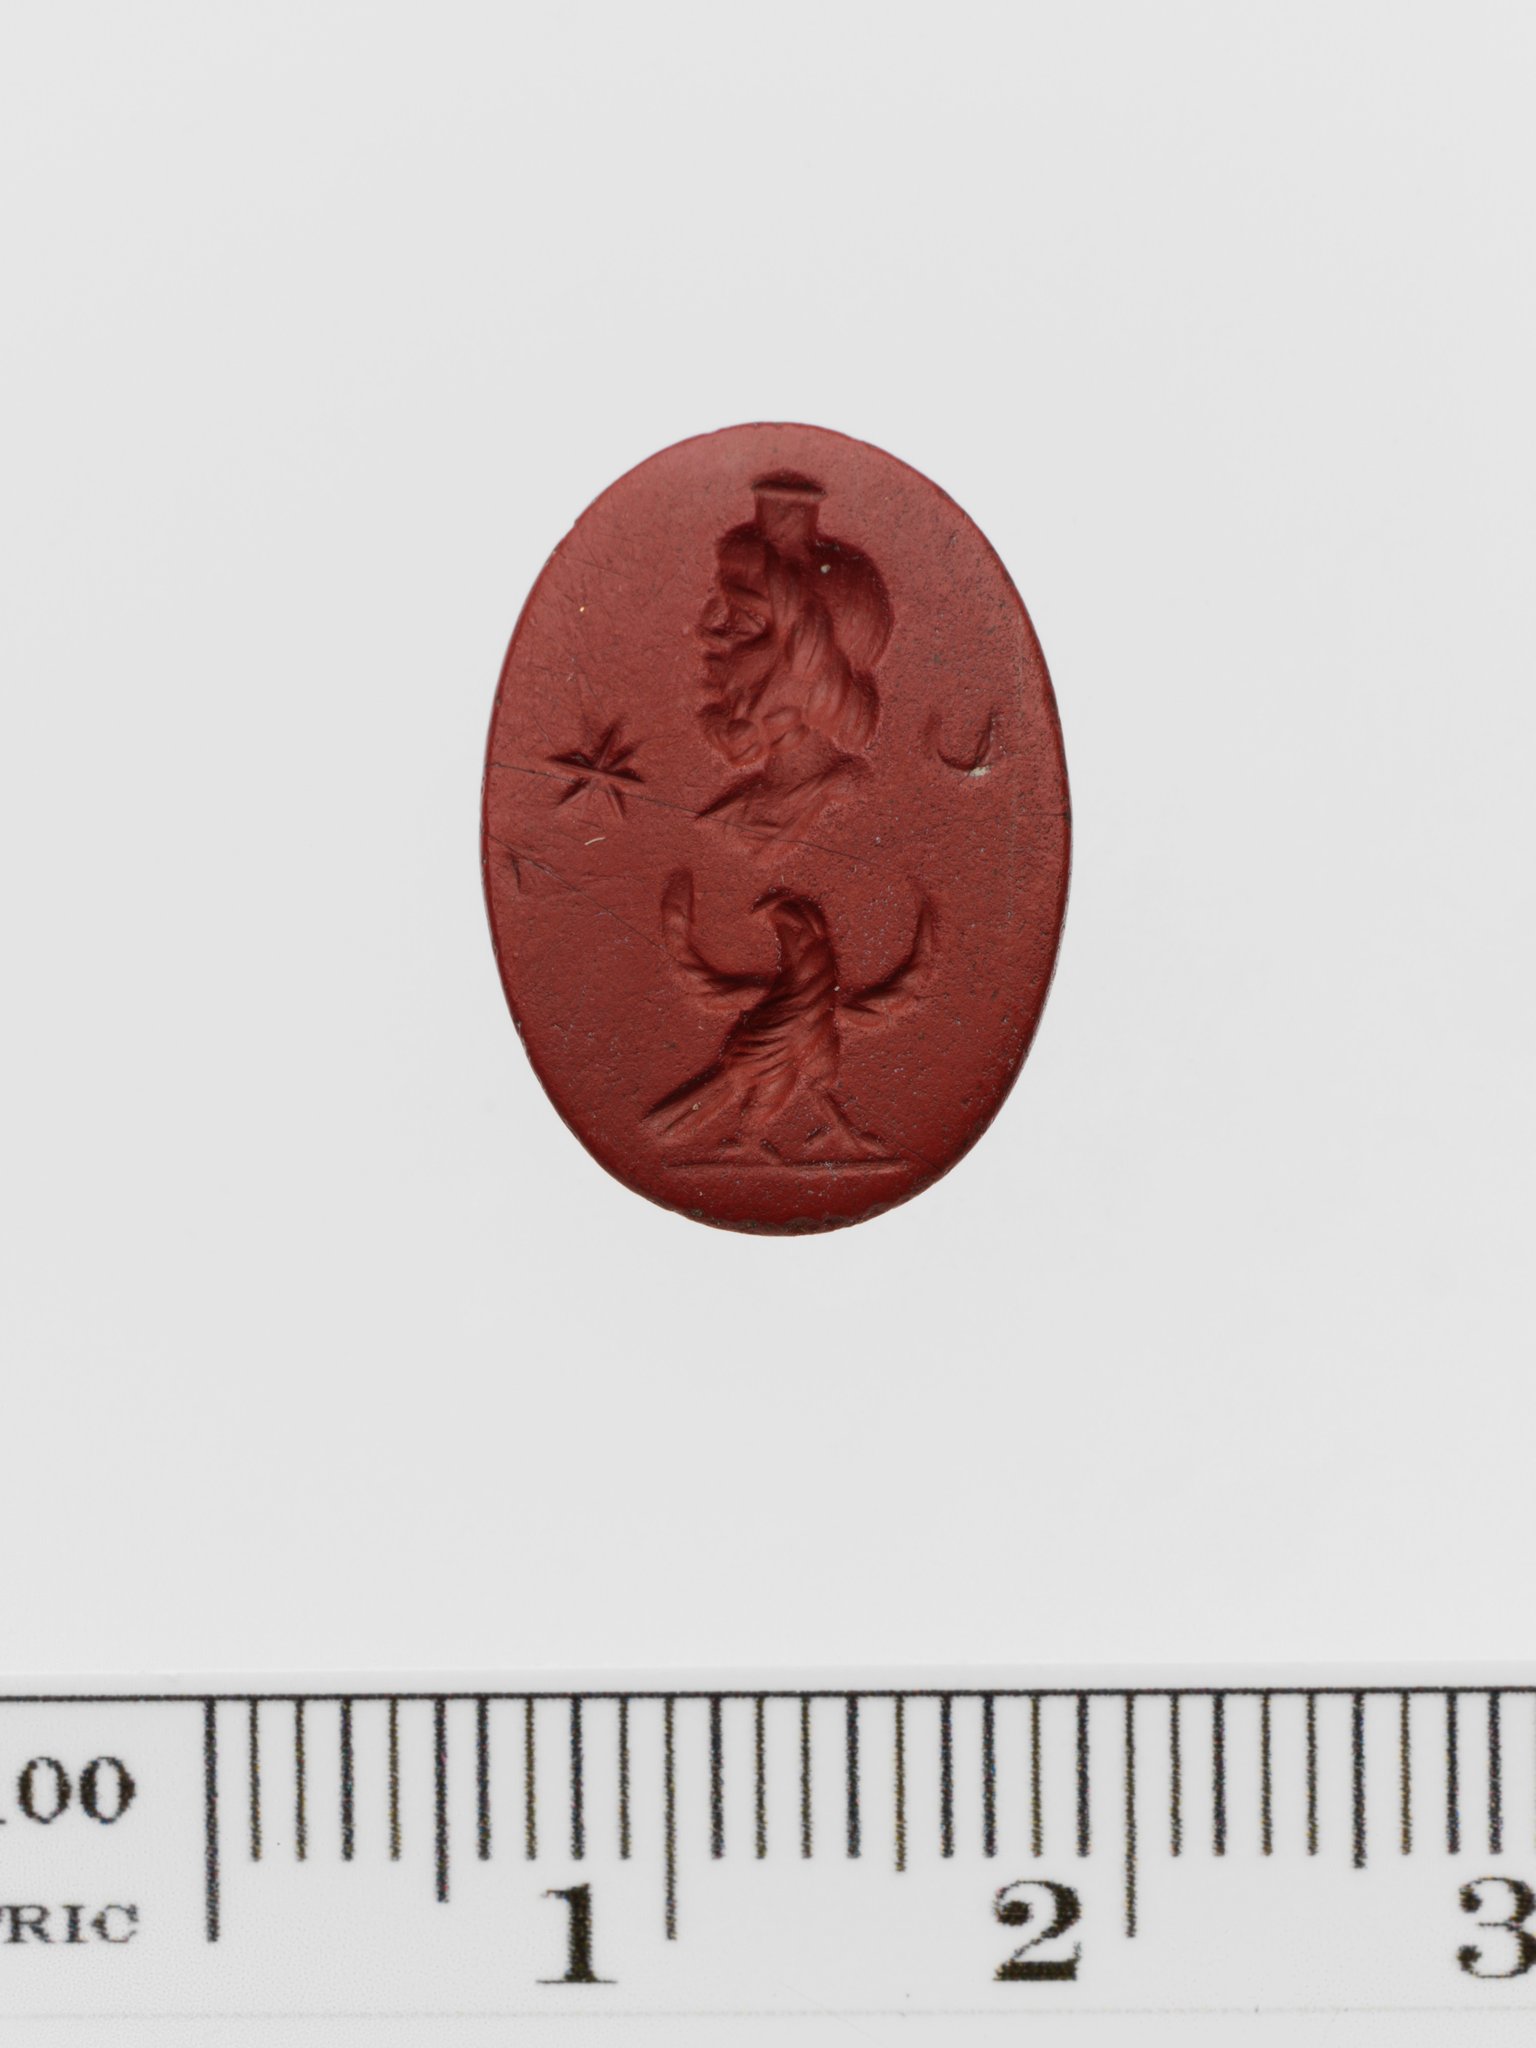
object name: intaglio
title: Jasper ring stone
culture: roman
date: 100 BCE-300 CE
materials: jasper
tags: eagles